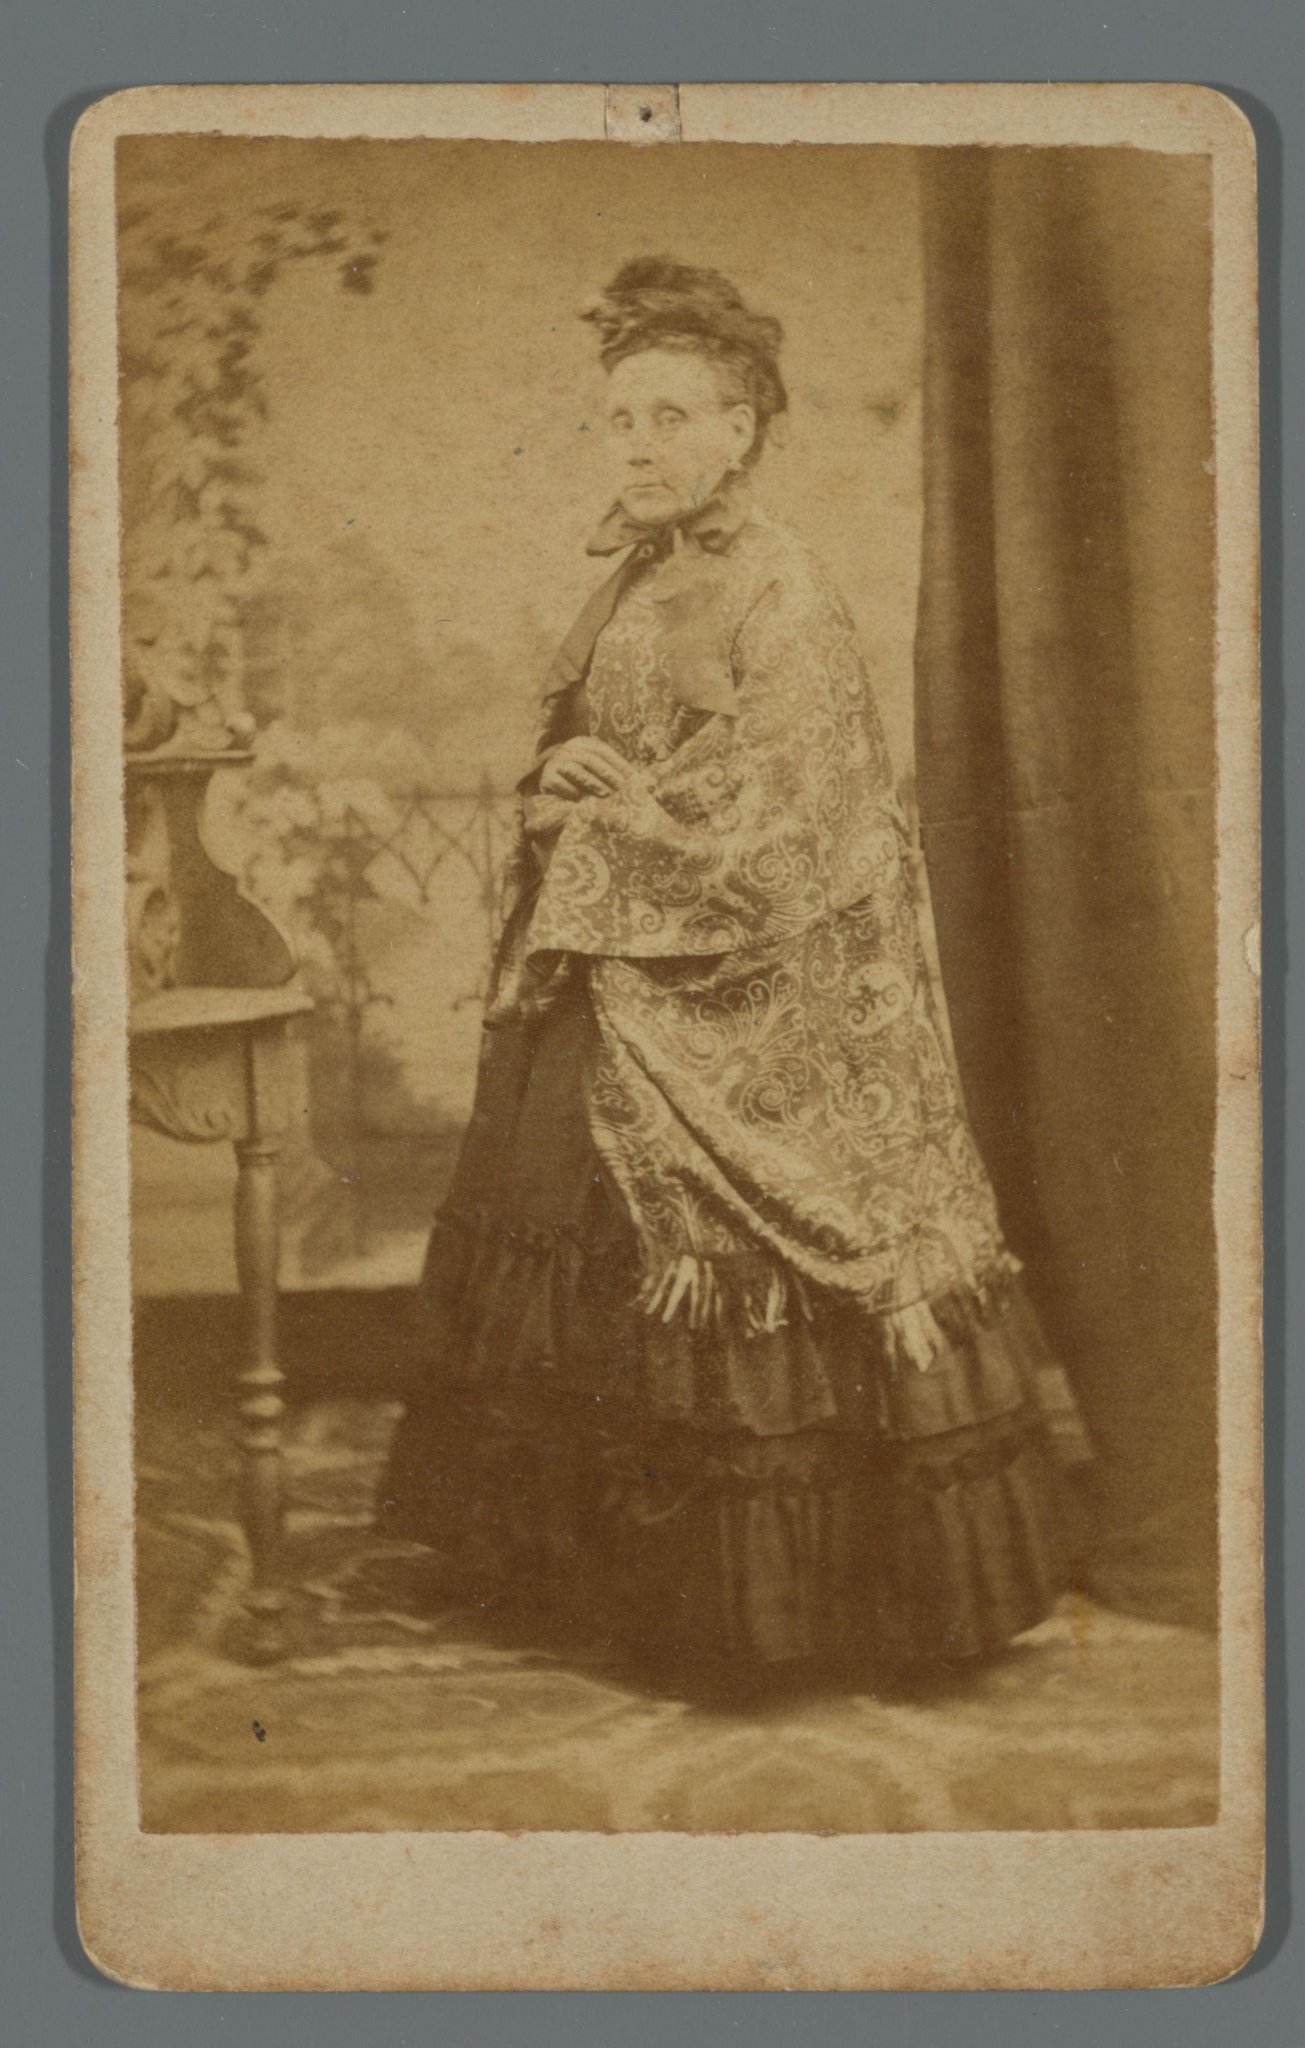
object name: carte de visite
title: Portret van een onbekende vrouw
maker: jan bikkers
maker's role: print maker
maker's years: 1830-1876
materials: cardboard, photographic support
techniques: albumen print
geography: rotterdam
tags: historical persons not known by name - bb - woman